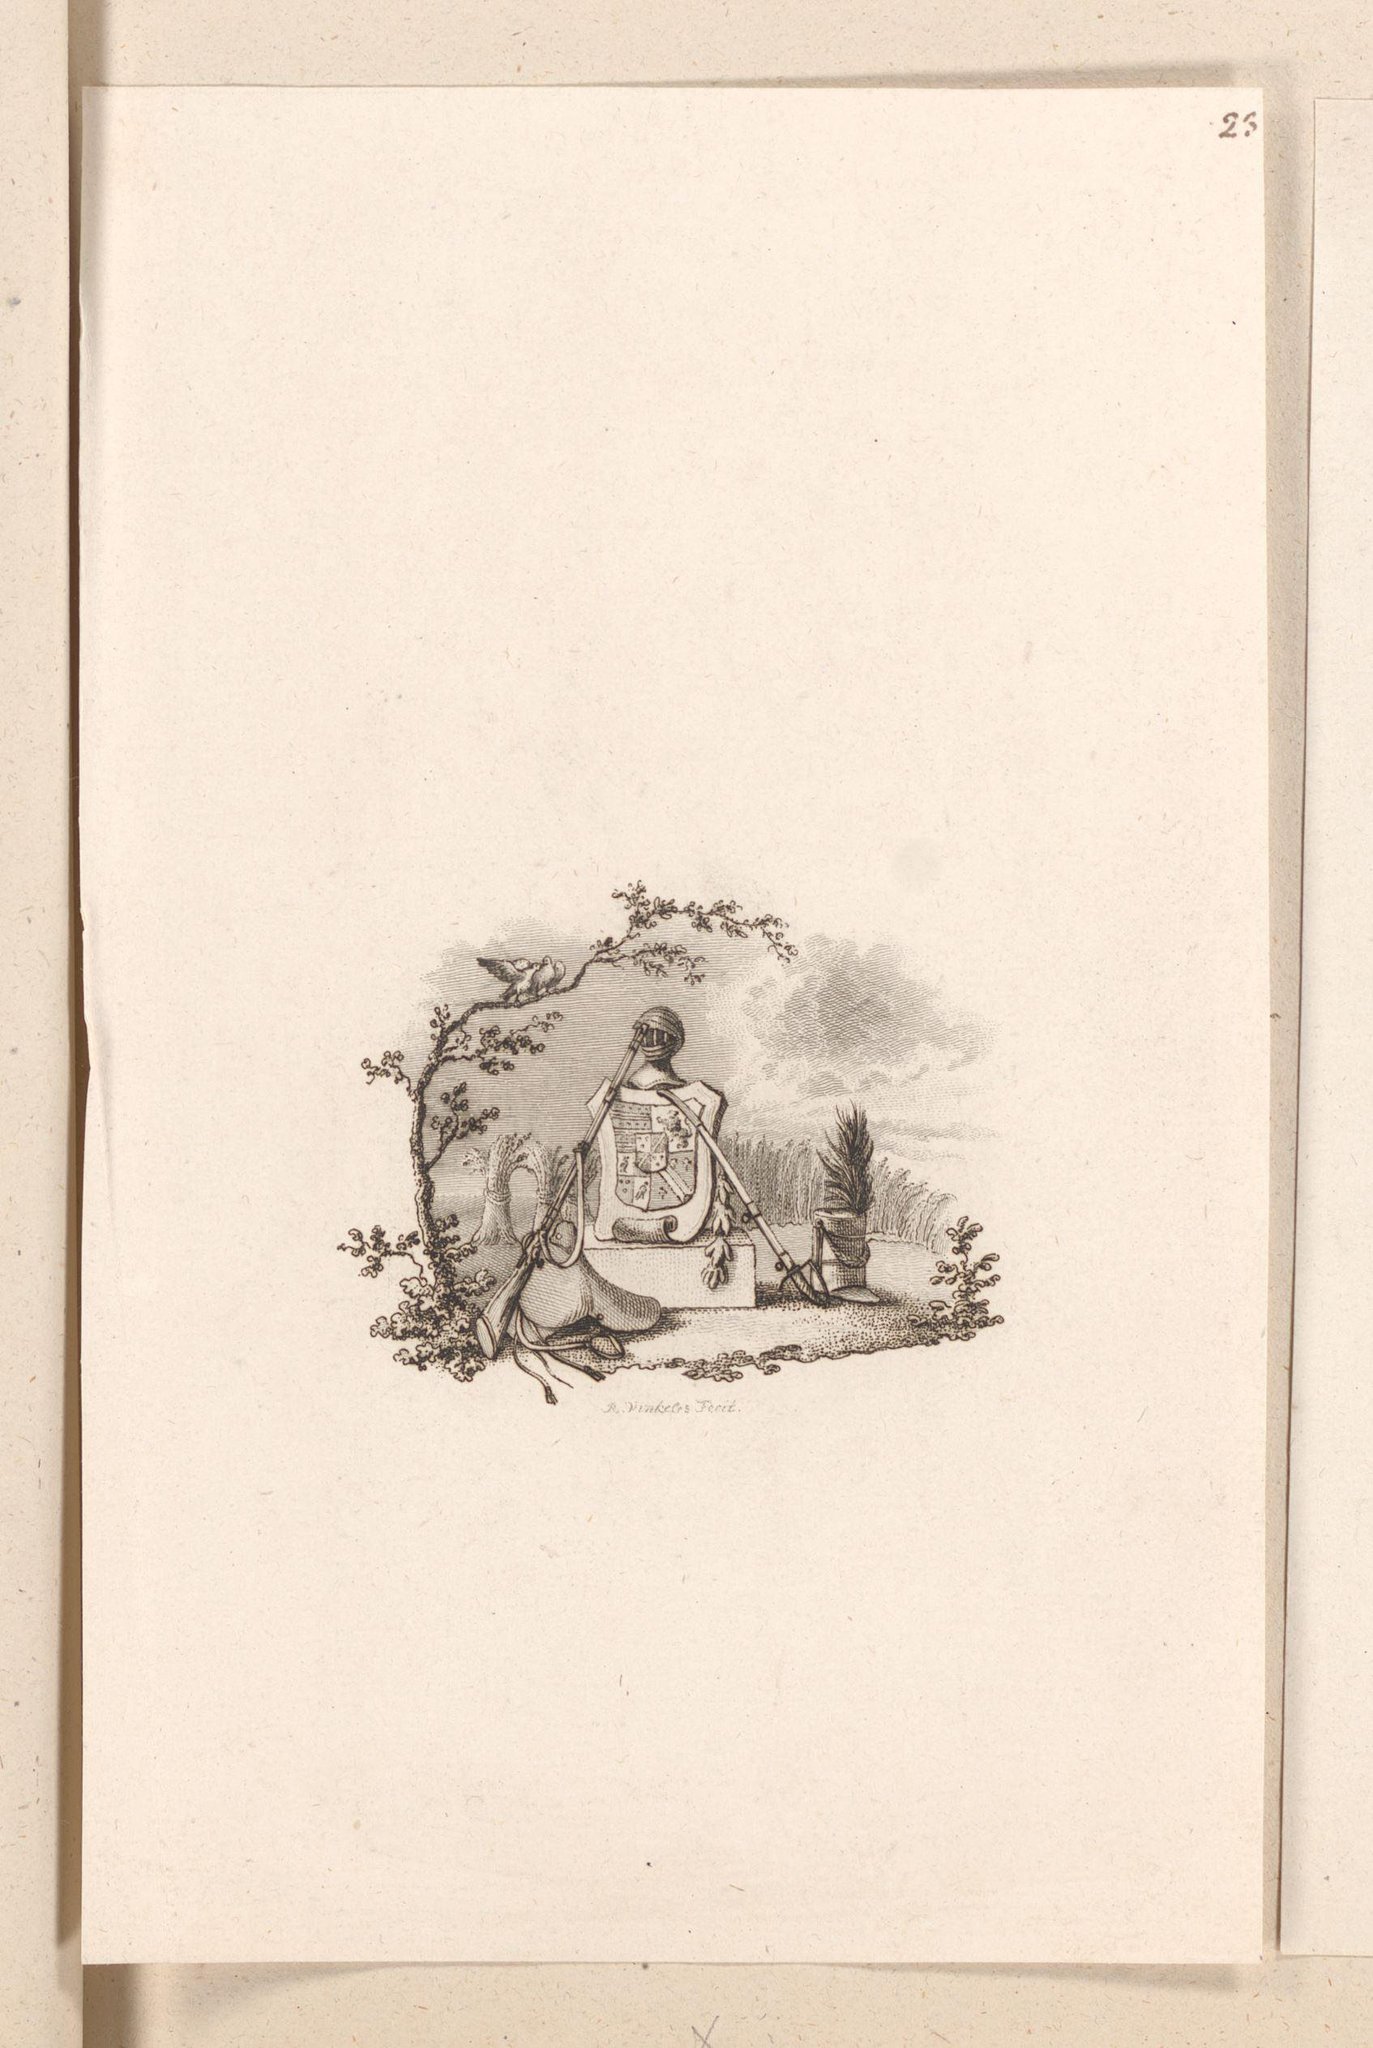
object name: titelblad, titelpagina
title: Landschap met wapenschild en militaire symbolen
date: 1809-1810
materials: paper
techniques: engraving, etching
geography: haarlem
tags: landscapes, other birds: dove, title-page, armorial bearing, heraldry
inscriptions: inscription: ‘23’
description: Proefdruk van een titelpagina gebruikt voor: Loosjes, Adriaan Pietersz. Lotgevallen van den heere Reinoud Jan van Golstein tot Scherpenzeel. Vier delen. Haarlem: A. Loosjes, 1809-1810.